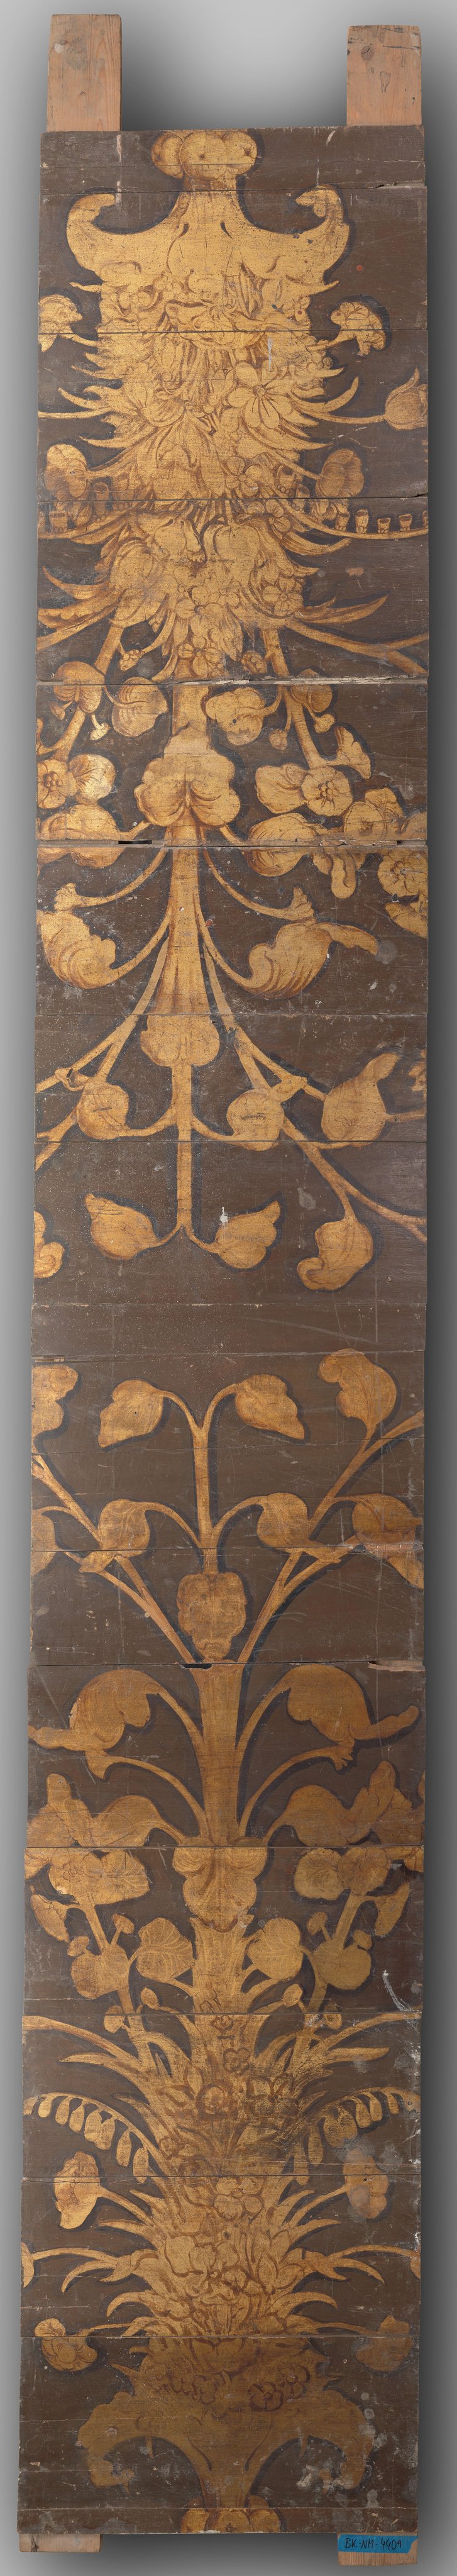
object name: vault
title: Tongewelf, samengesteld uit eiken planken, beschilderd met grotesken en acanthusranken, afgewende vrouwenfiguren met onderlijven die eindigen in klauwen en voluten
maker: Anonymous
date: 1600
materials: wood, paint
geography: northern netherlands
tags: the hague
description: Gewelf bestaande uit ongeveer 150 panelen van verschillende grootte. Onderdelen 149 t/m 154, onderdelen 267 t/m 273, onderdelen 275 t/m 280, onderdelen 44 t/m 47, onderdelen 86 t/m 95, onderdelen 155 t/m 162 en onderdelen 75 t/m 85.